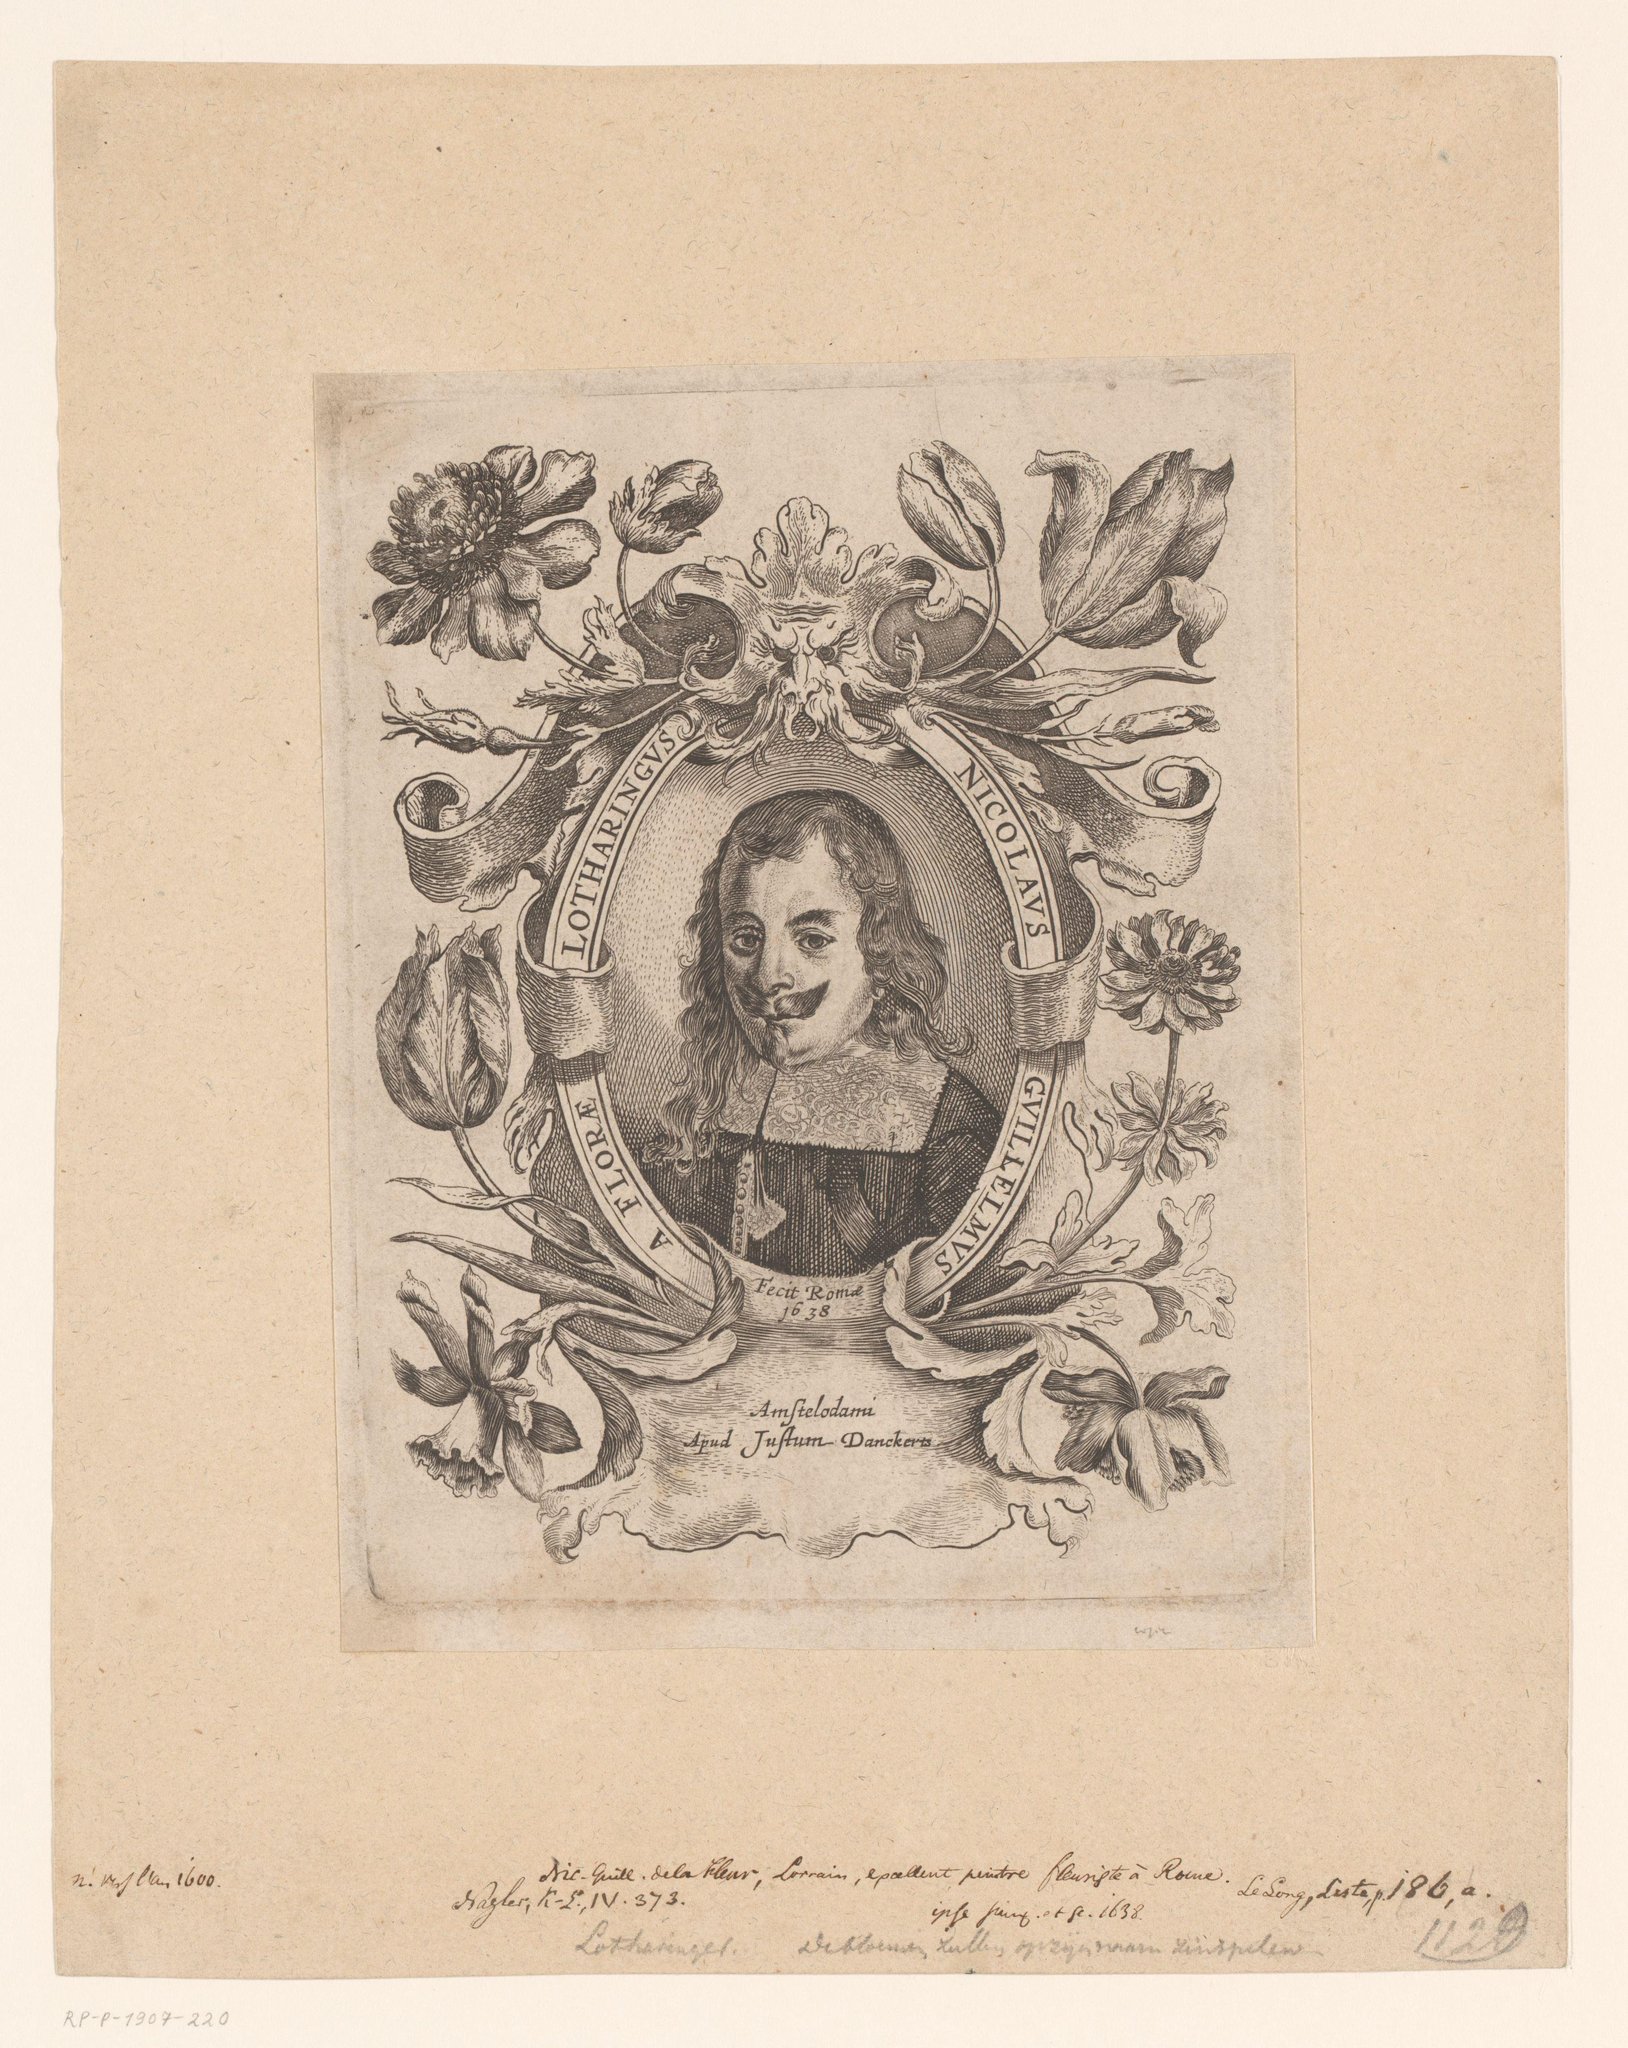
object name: print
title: Zelfportret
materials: paper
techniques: engraving, etching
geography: amsterdam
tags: paris, nicolas guillaume de la fleur, flowers, historical persons, portrait, self-portrait of graphic artist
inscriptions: inscription: ‘n. [...] 1600. Nic. Guill. dela Fleur, Lorrain, excellent peintre fleuriste à Rome. Nagler, K-Ea, IV. 373. ipse pinx. et sc. 1638’